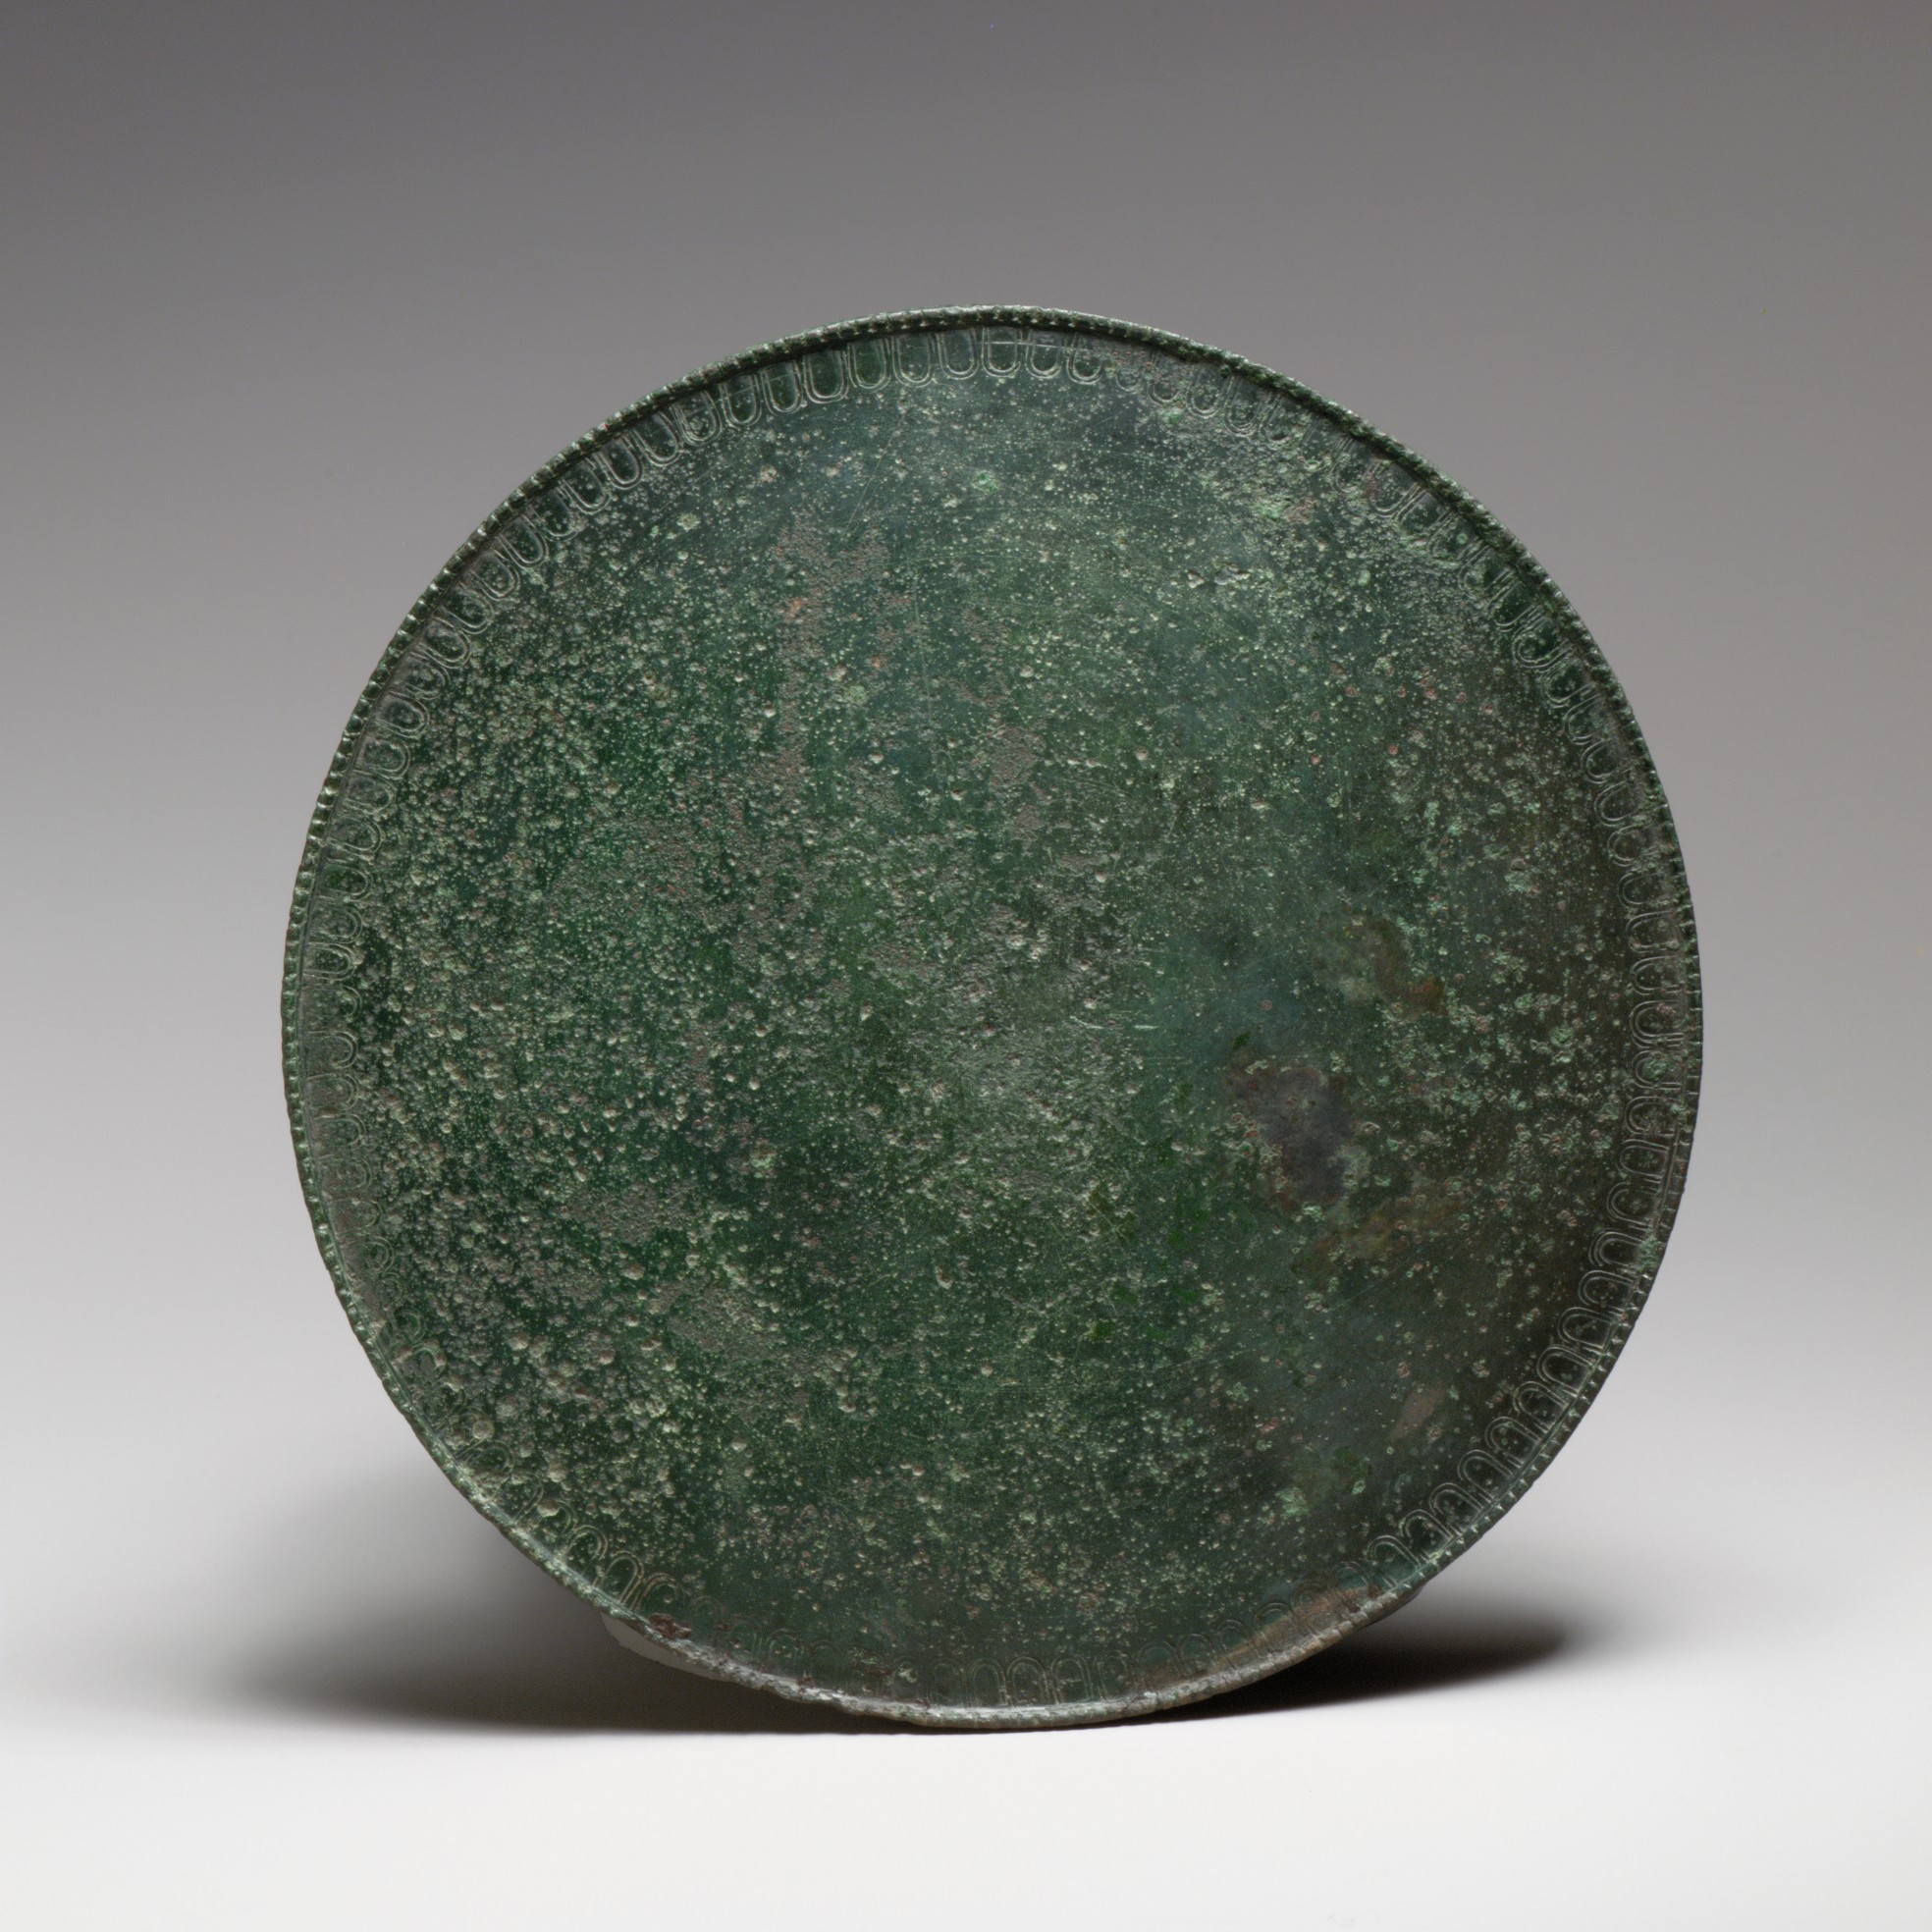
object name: mirror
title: Bronze mirror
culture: greek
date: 567-535 BCE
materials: bronze